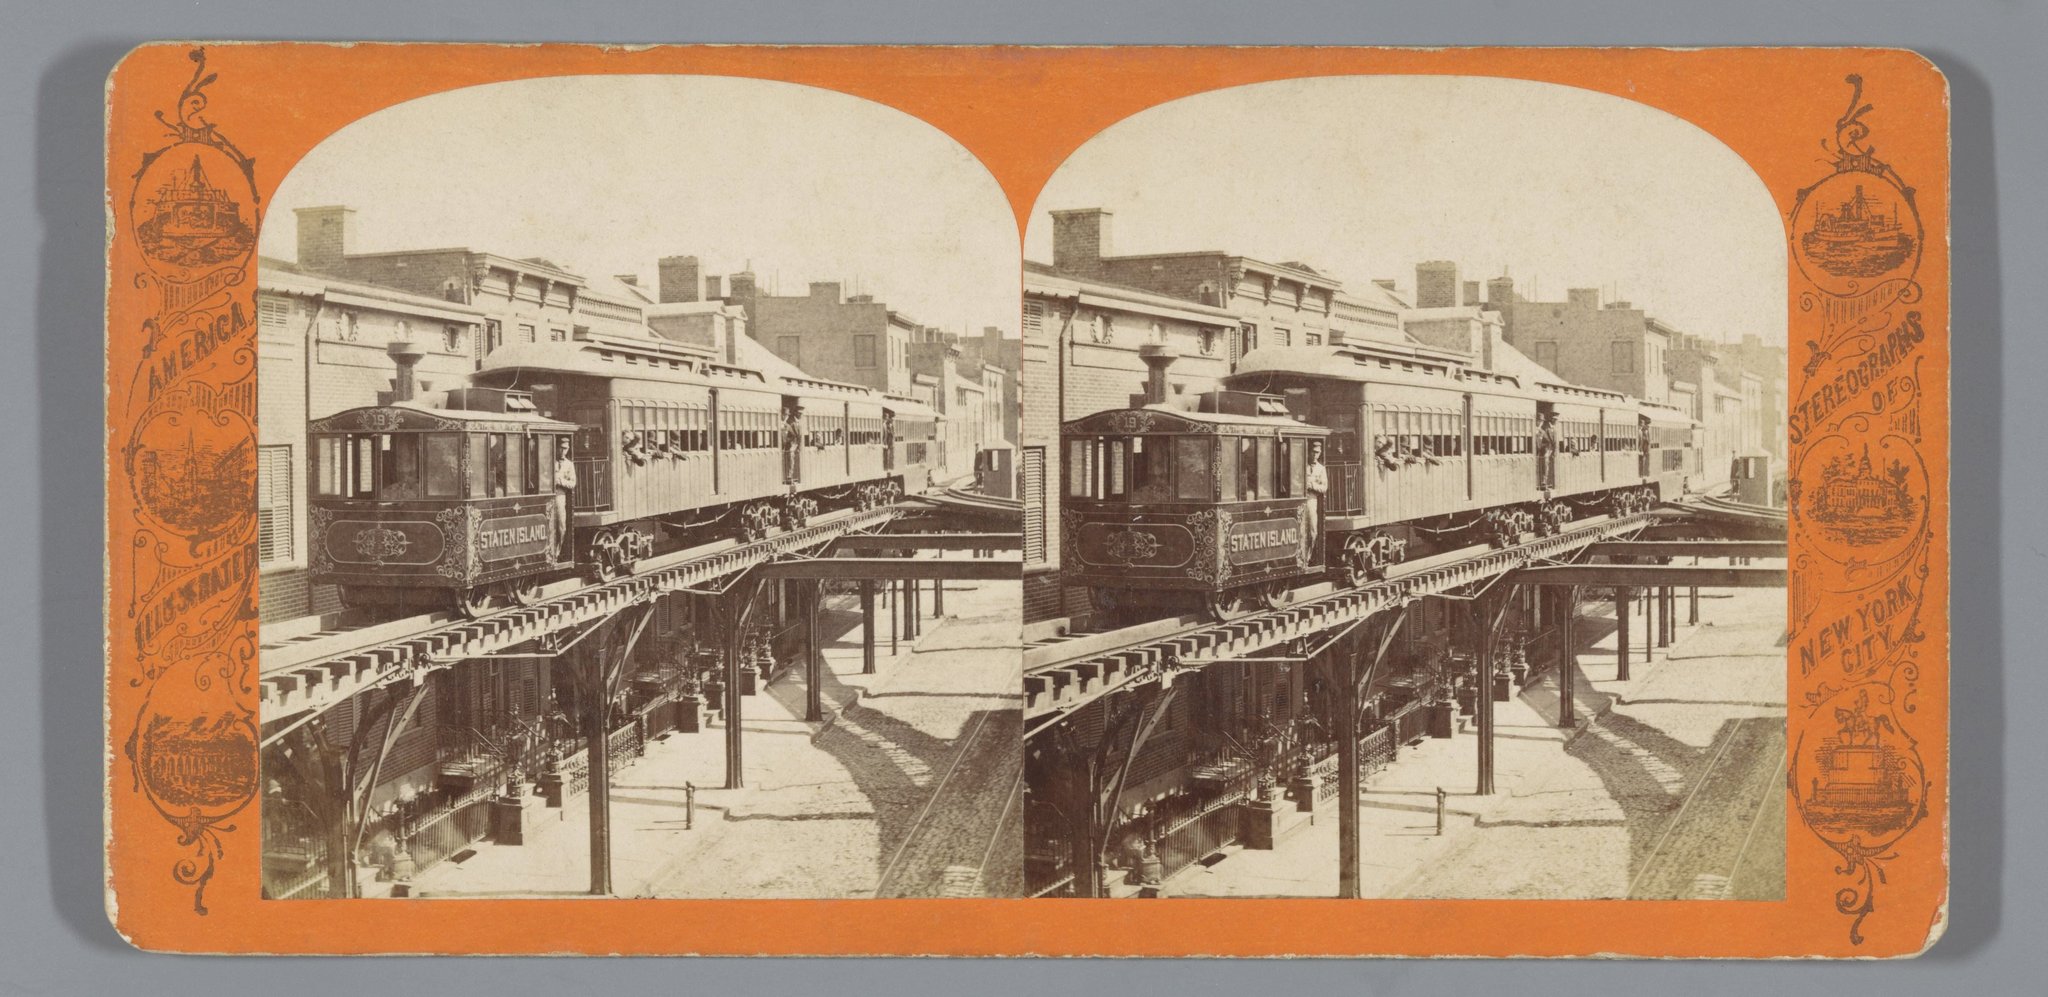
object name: stereograph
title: N.Y. Elevated R.R.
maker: george gardner rockwood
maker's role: fotograaf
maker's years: 1832-1911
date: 1870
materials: cardboard, paper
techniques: albumen print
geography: new york city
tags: railway, tramway; rack railway, new york (city)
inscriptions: number: ‘3’, inscription: ‘Tribune Building./ Wall Street Above William./ Wall Street below William./ Wall Street Below Nassau. (...)’, inscription: ‘afgebeeld p 137. [onleesbaar], veiling 7-2-70/ "This rare photograph by Rockwood is dated may 15 1870’